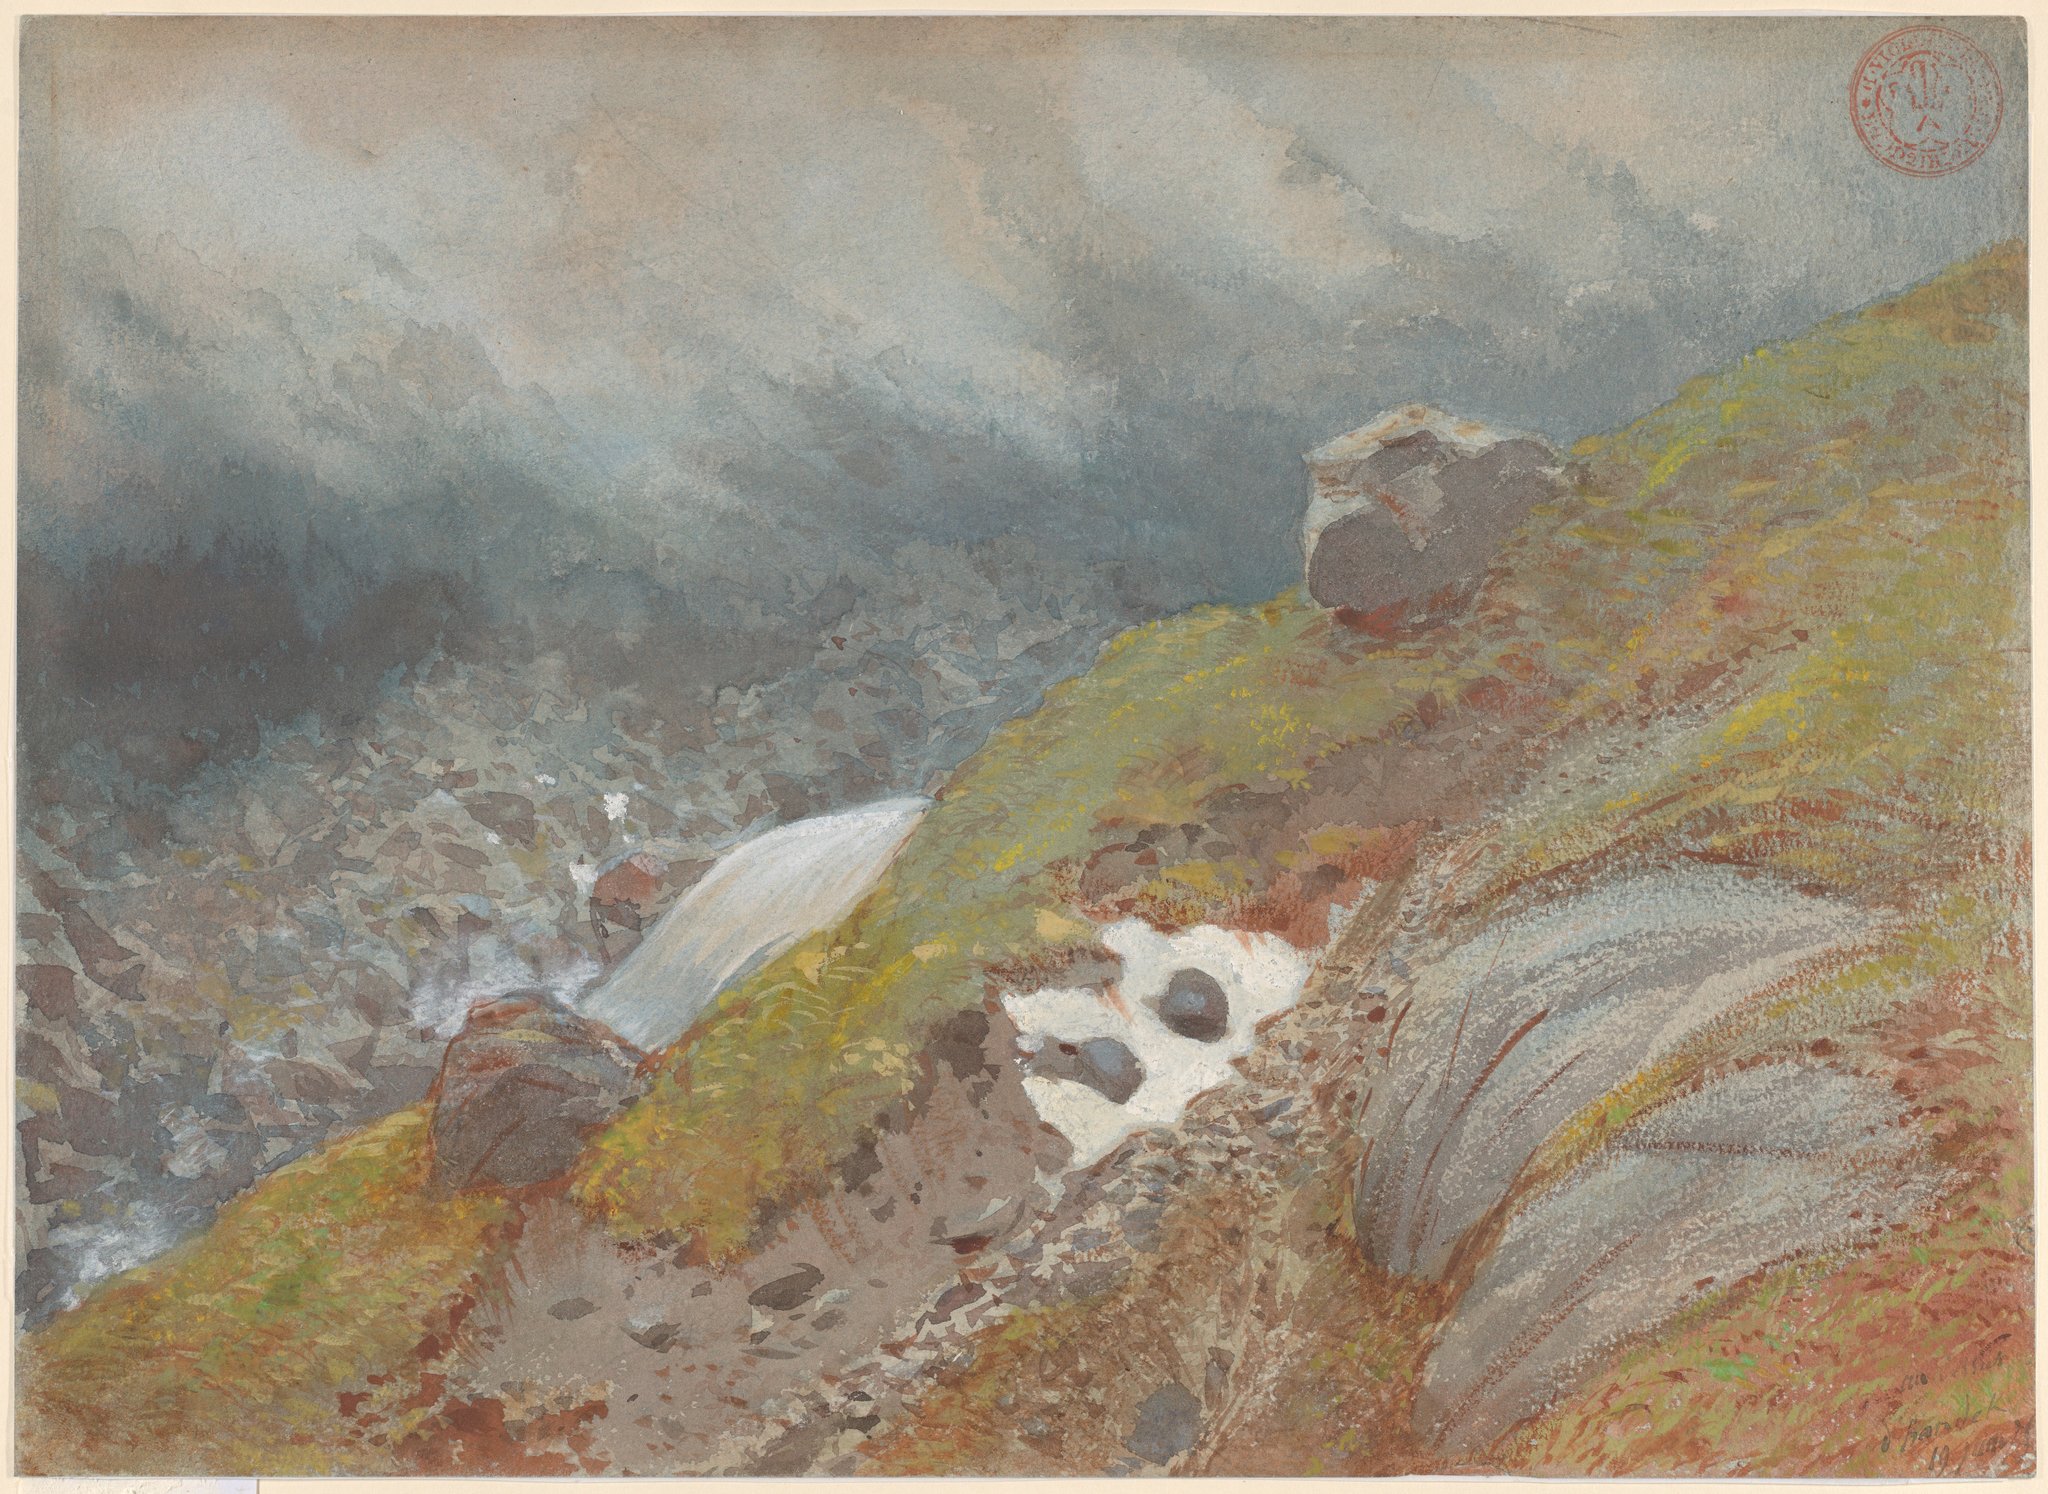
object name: drawing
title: View Above Handeck, Switzerland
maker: eugène-emmanuel viollet-le-duc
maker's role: artist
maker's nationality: french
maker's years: 1814-1879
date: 1875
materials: gouache, paper, watercolor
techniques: heightening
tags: landscapes